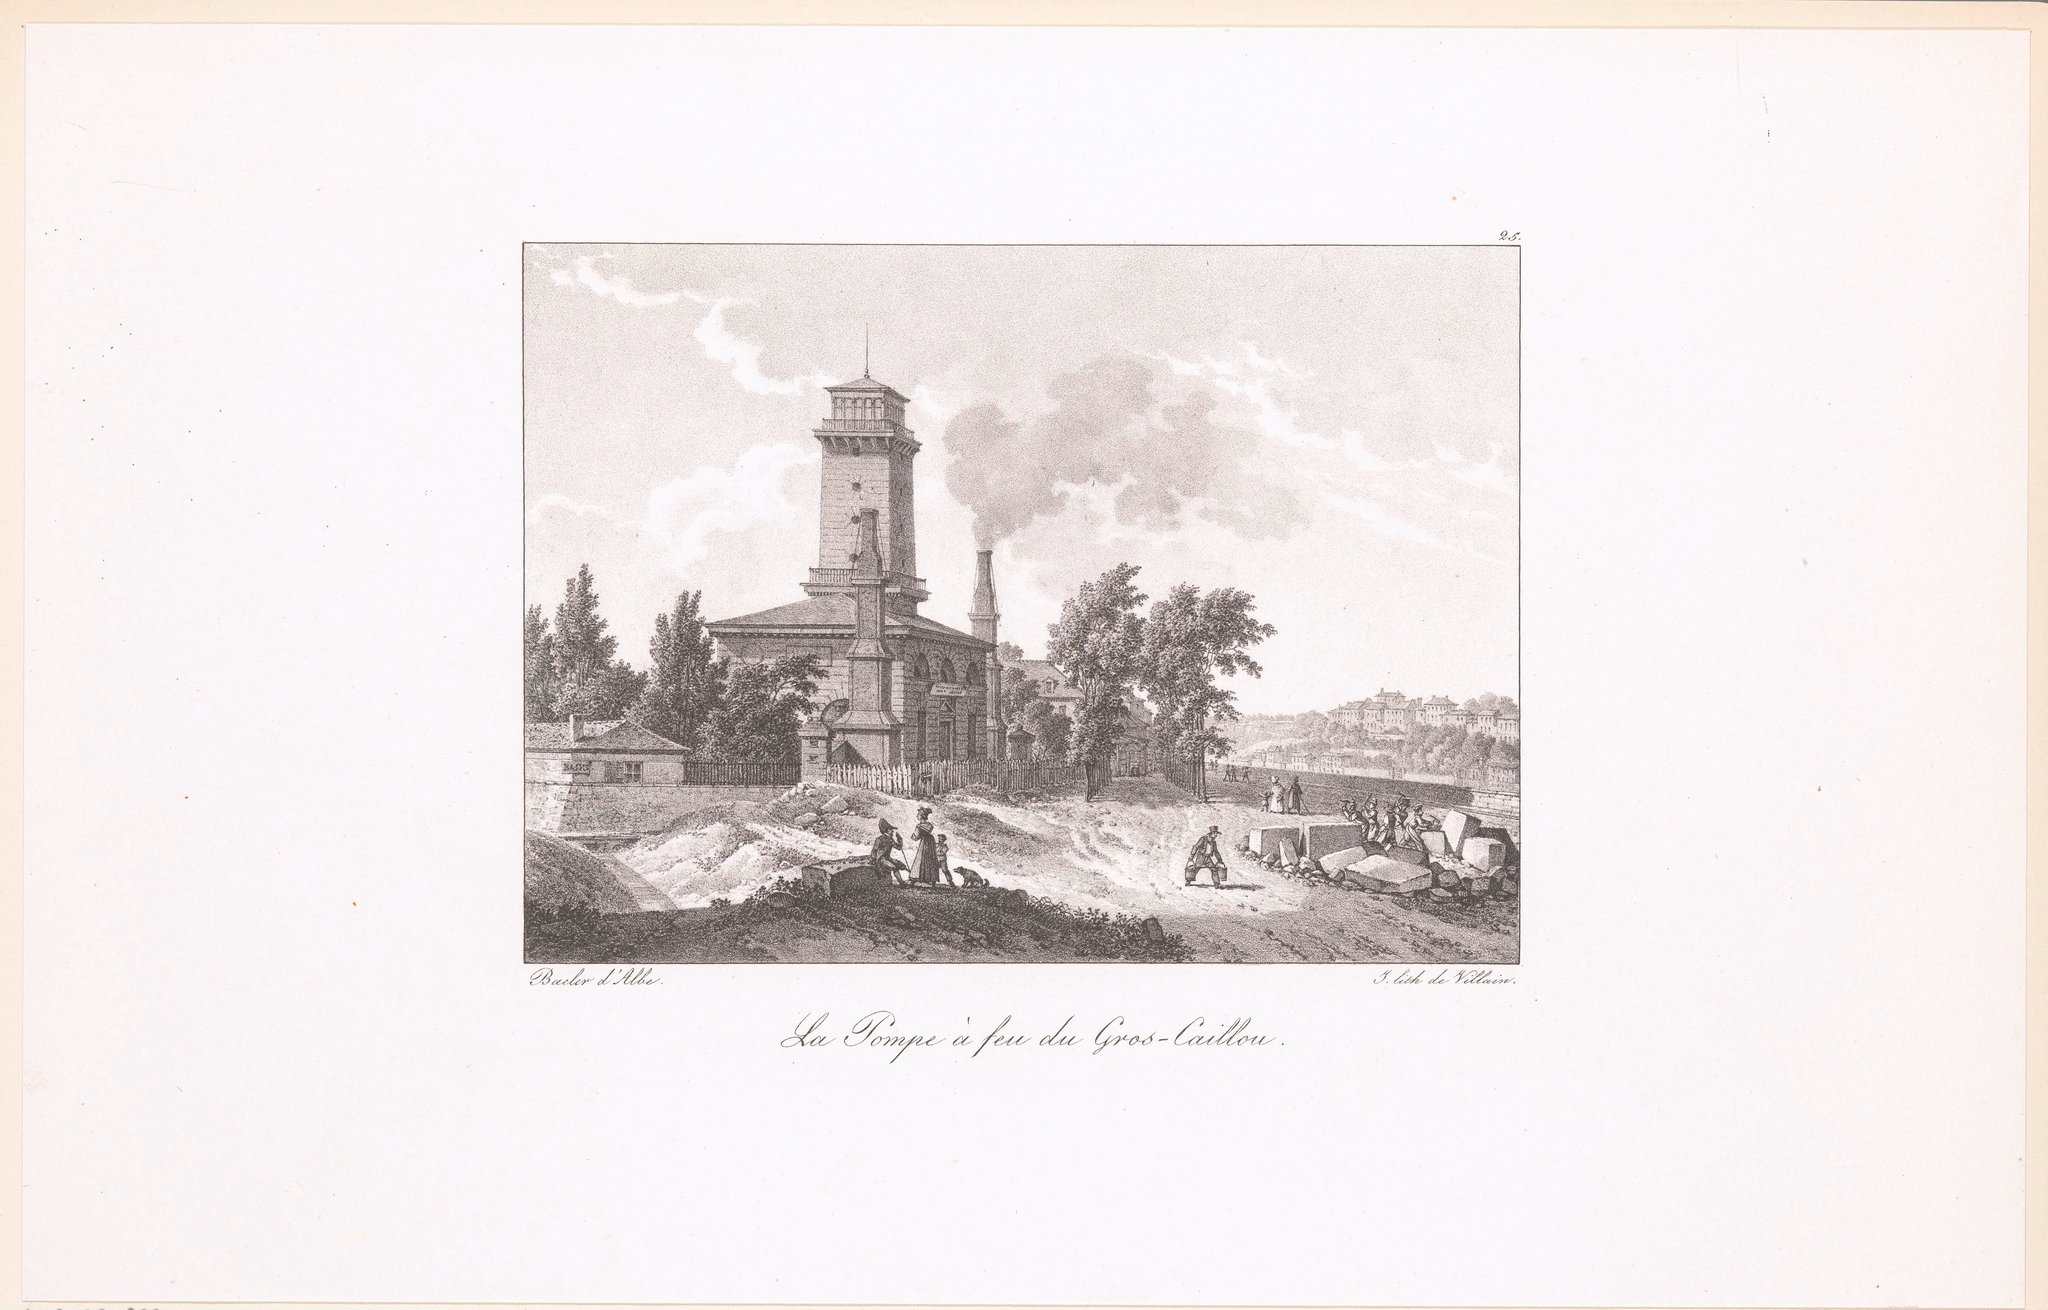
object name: print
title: Pittoreske gezichten op Parijs en omgeving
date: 1822-1824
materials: paper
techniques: lithograph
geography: paris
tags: stone-cutter, stone-sawyer, river bank, machines, engines ~ crafts and industries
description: De stoom- of 'vuur'machine van Gros-Caillou pompte het water van de Seine onder atmosferische druk omhoog om diverse fonteinen in Parijs van water te voorzien. In 1858 raakte de machine in onbruik en in 1909 werd het gebouw afgebroken.